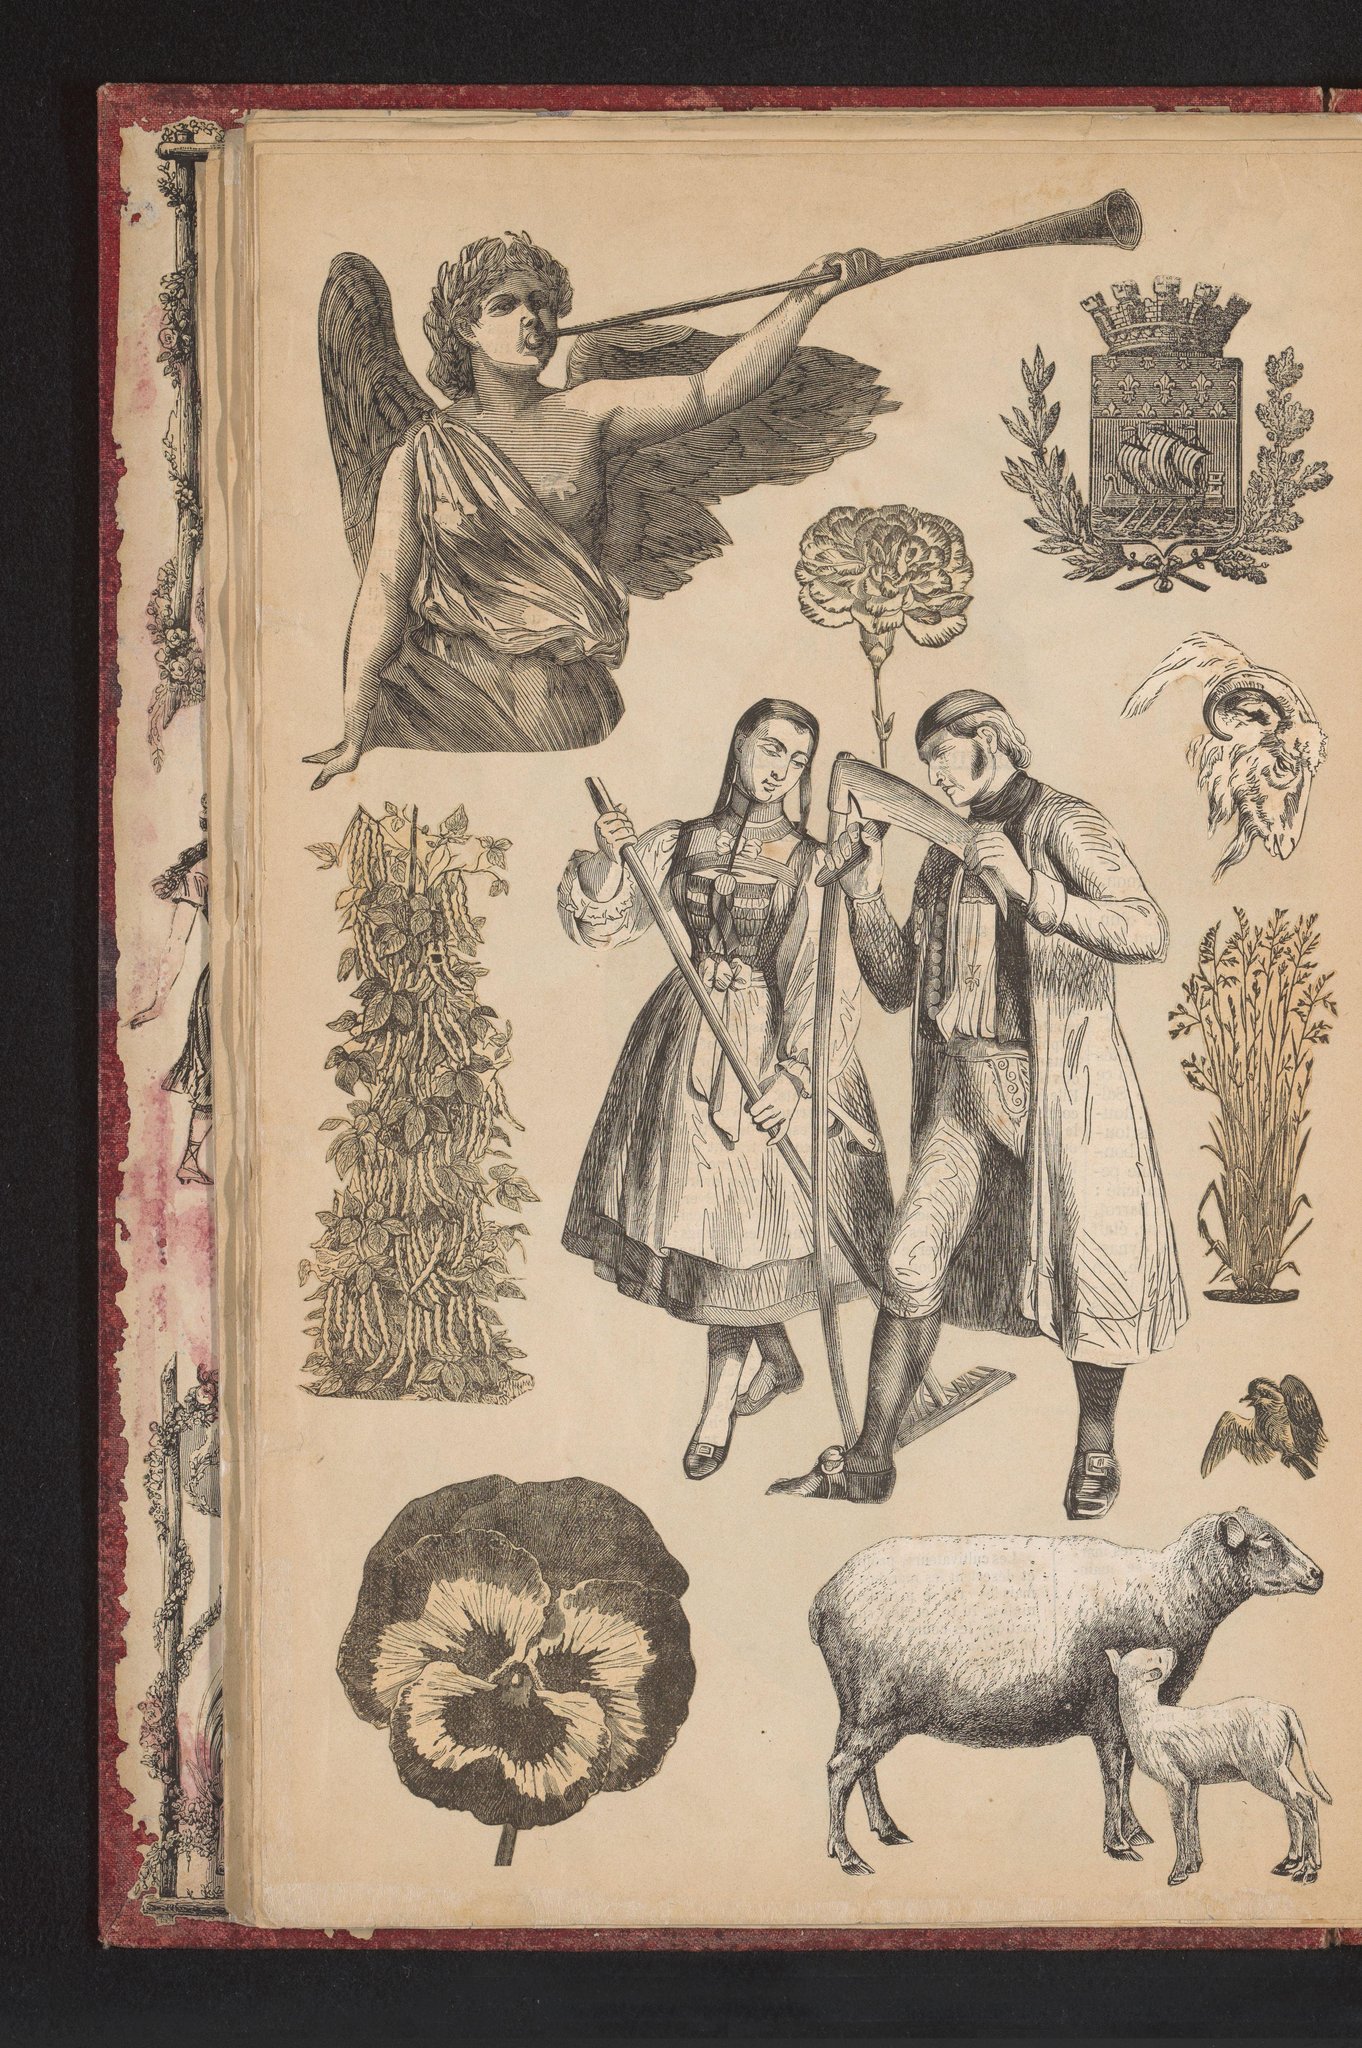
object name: collage visual work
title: Collage van uitgeknipte prenten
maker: Anonymous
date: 1870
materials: paper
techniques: engraving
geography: paris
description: Collage van uitgeknipte prenten. Onderdeel van een album met 32 bladen, aan beide zijden beplakt met uitgeknipte prenten, vermoedelijk afkomstig uit 19e-eeuwse tijdschiften.